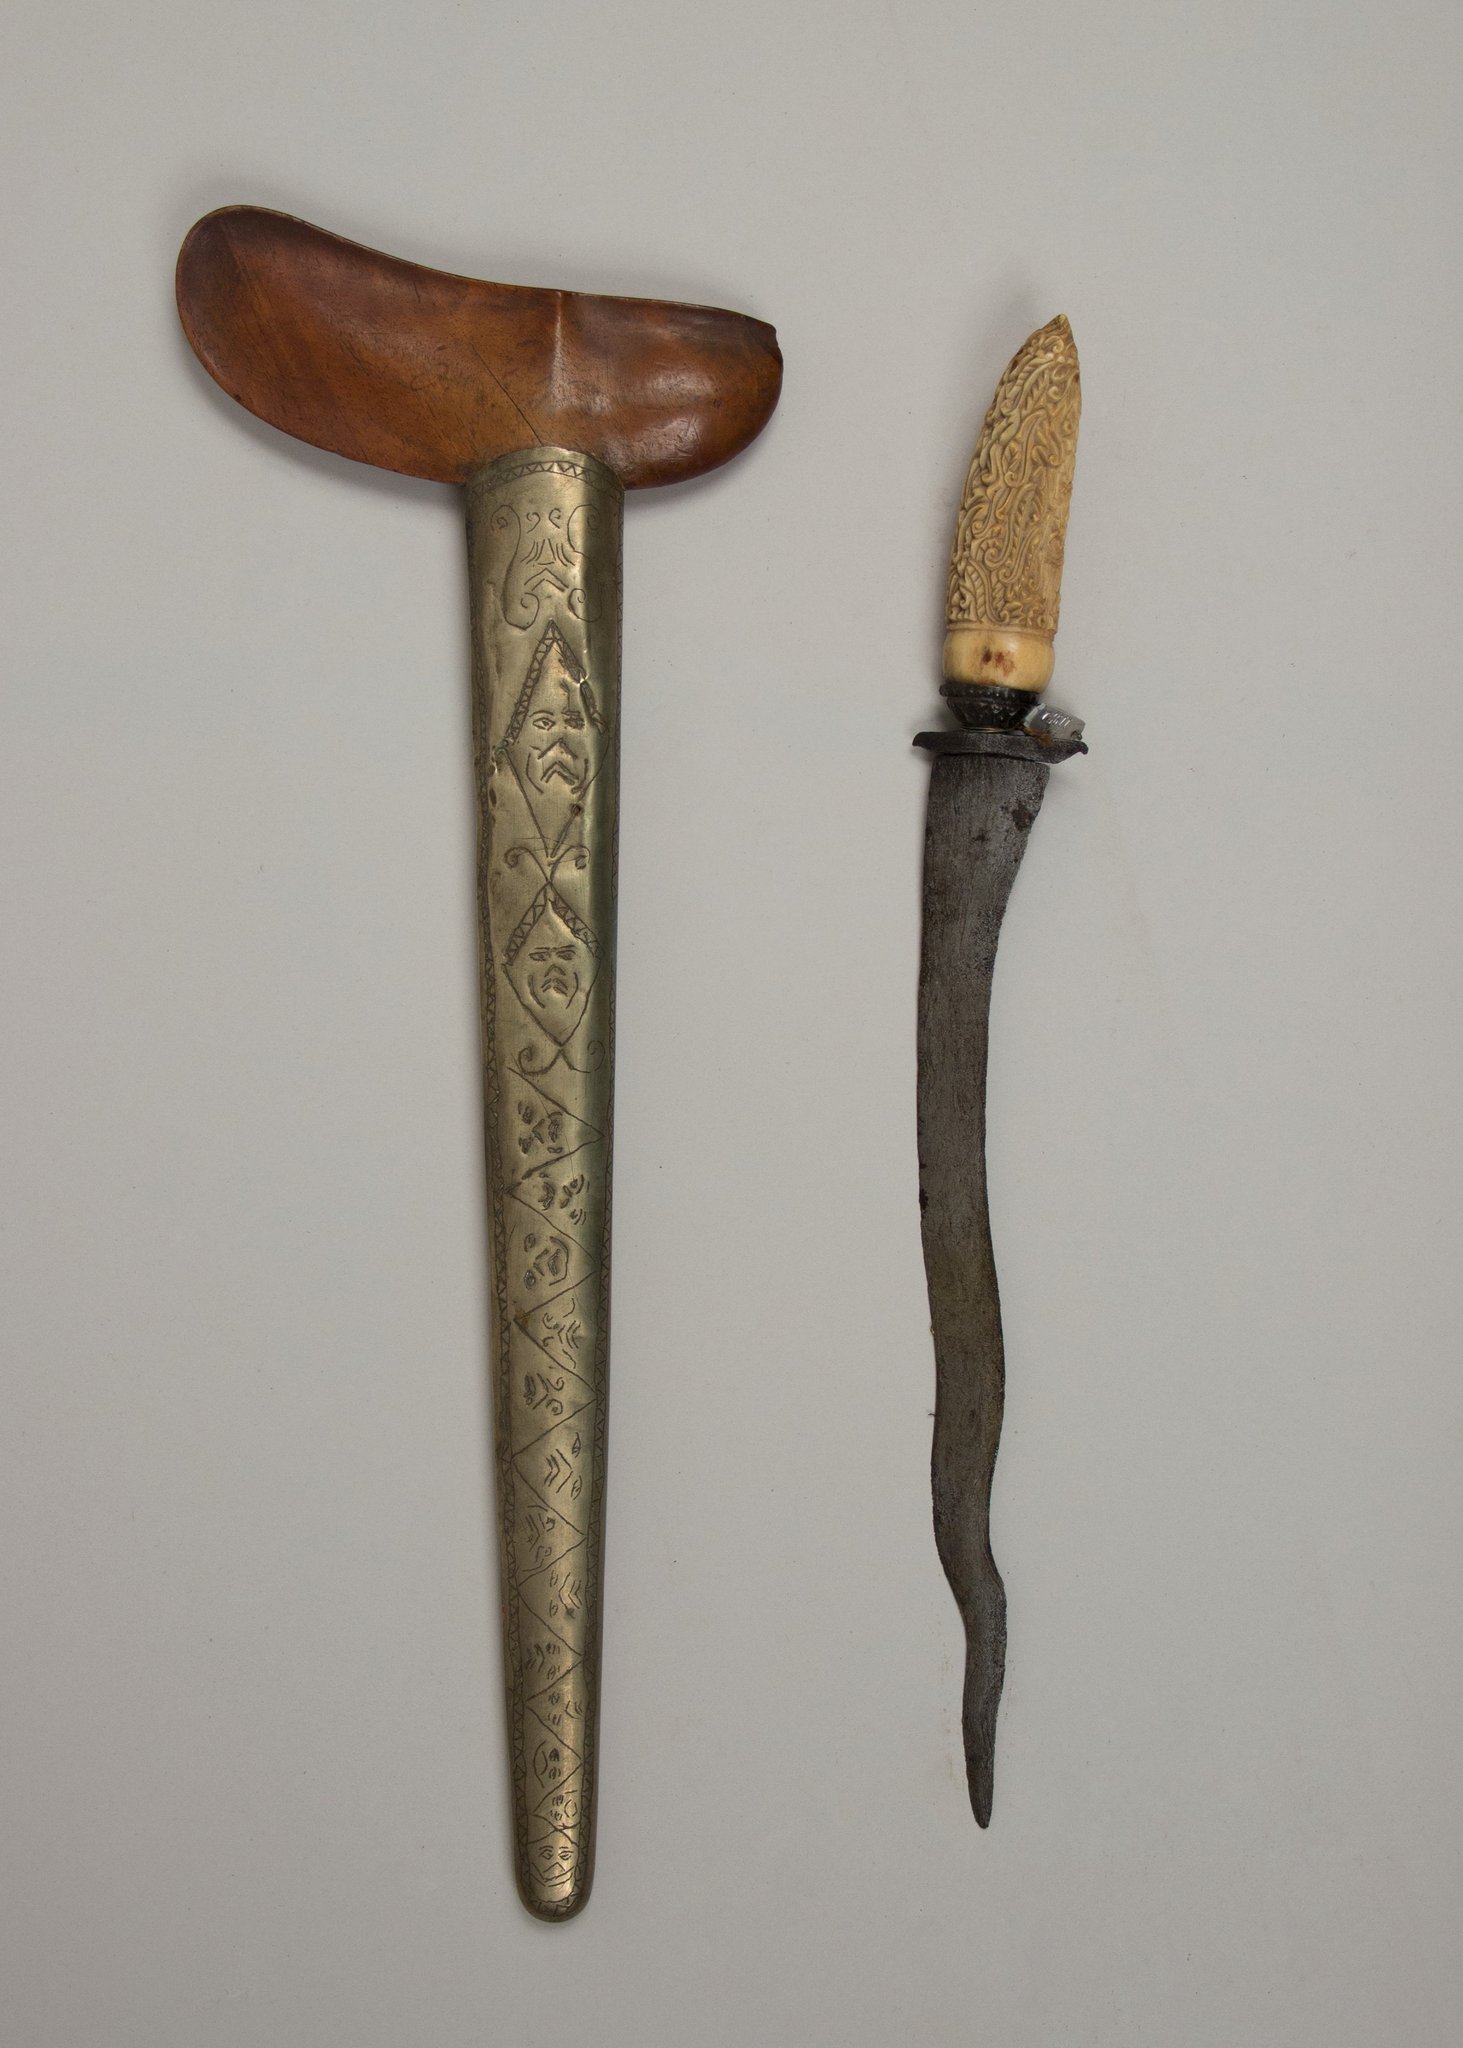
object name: kris with sheath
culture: javanese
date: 1501-1900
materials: brass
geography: indonesia